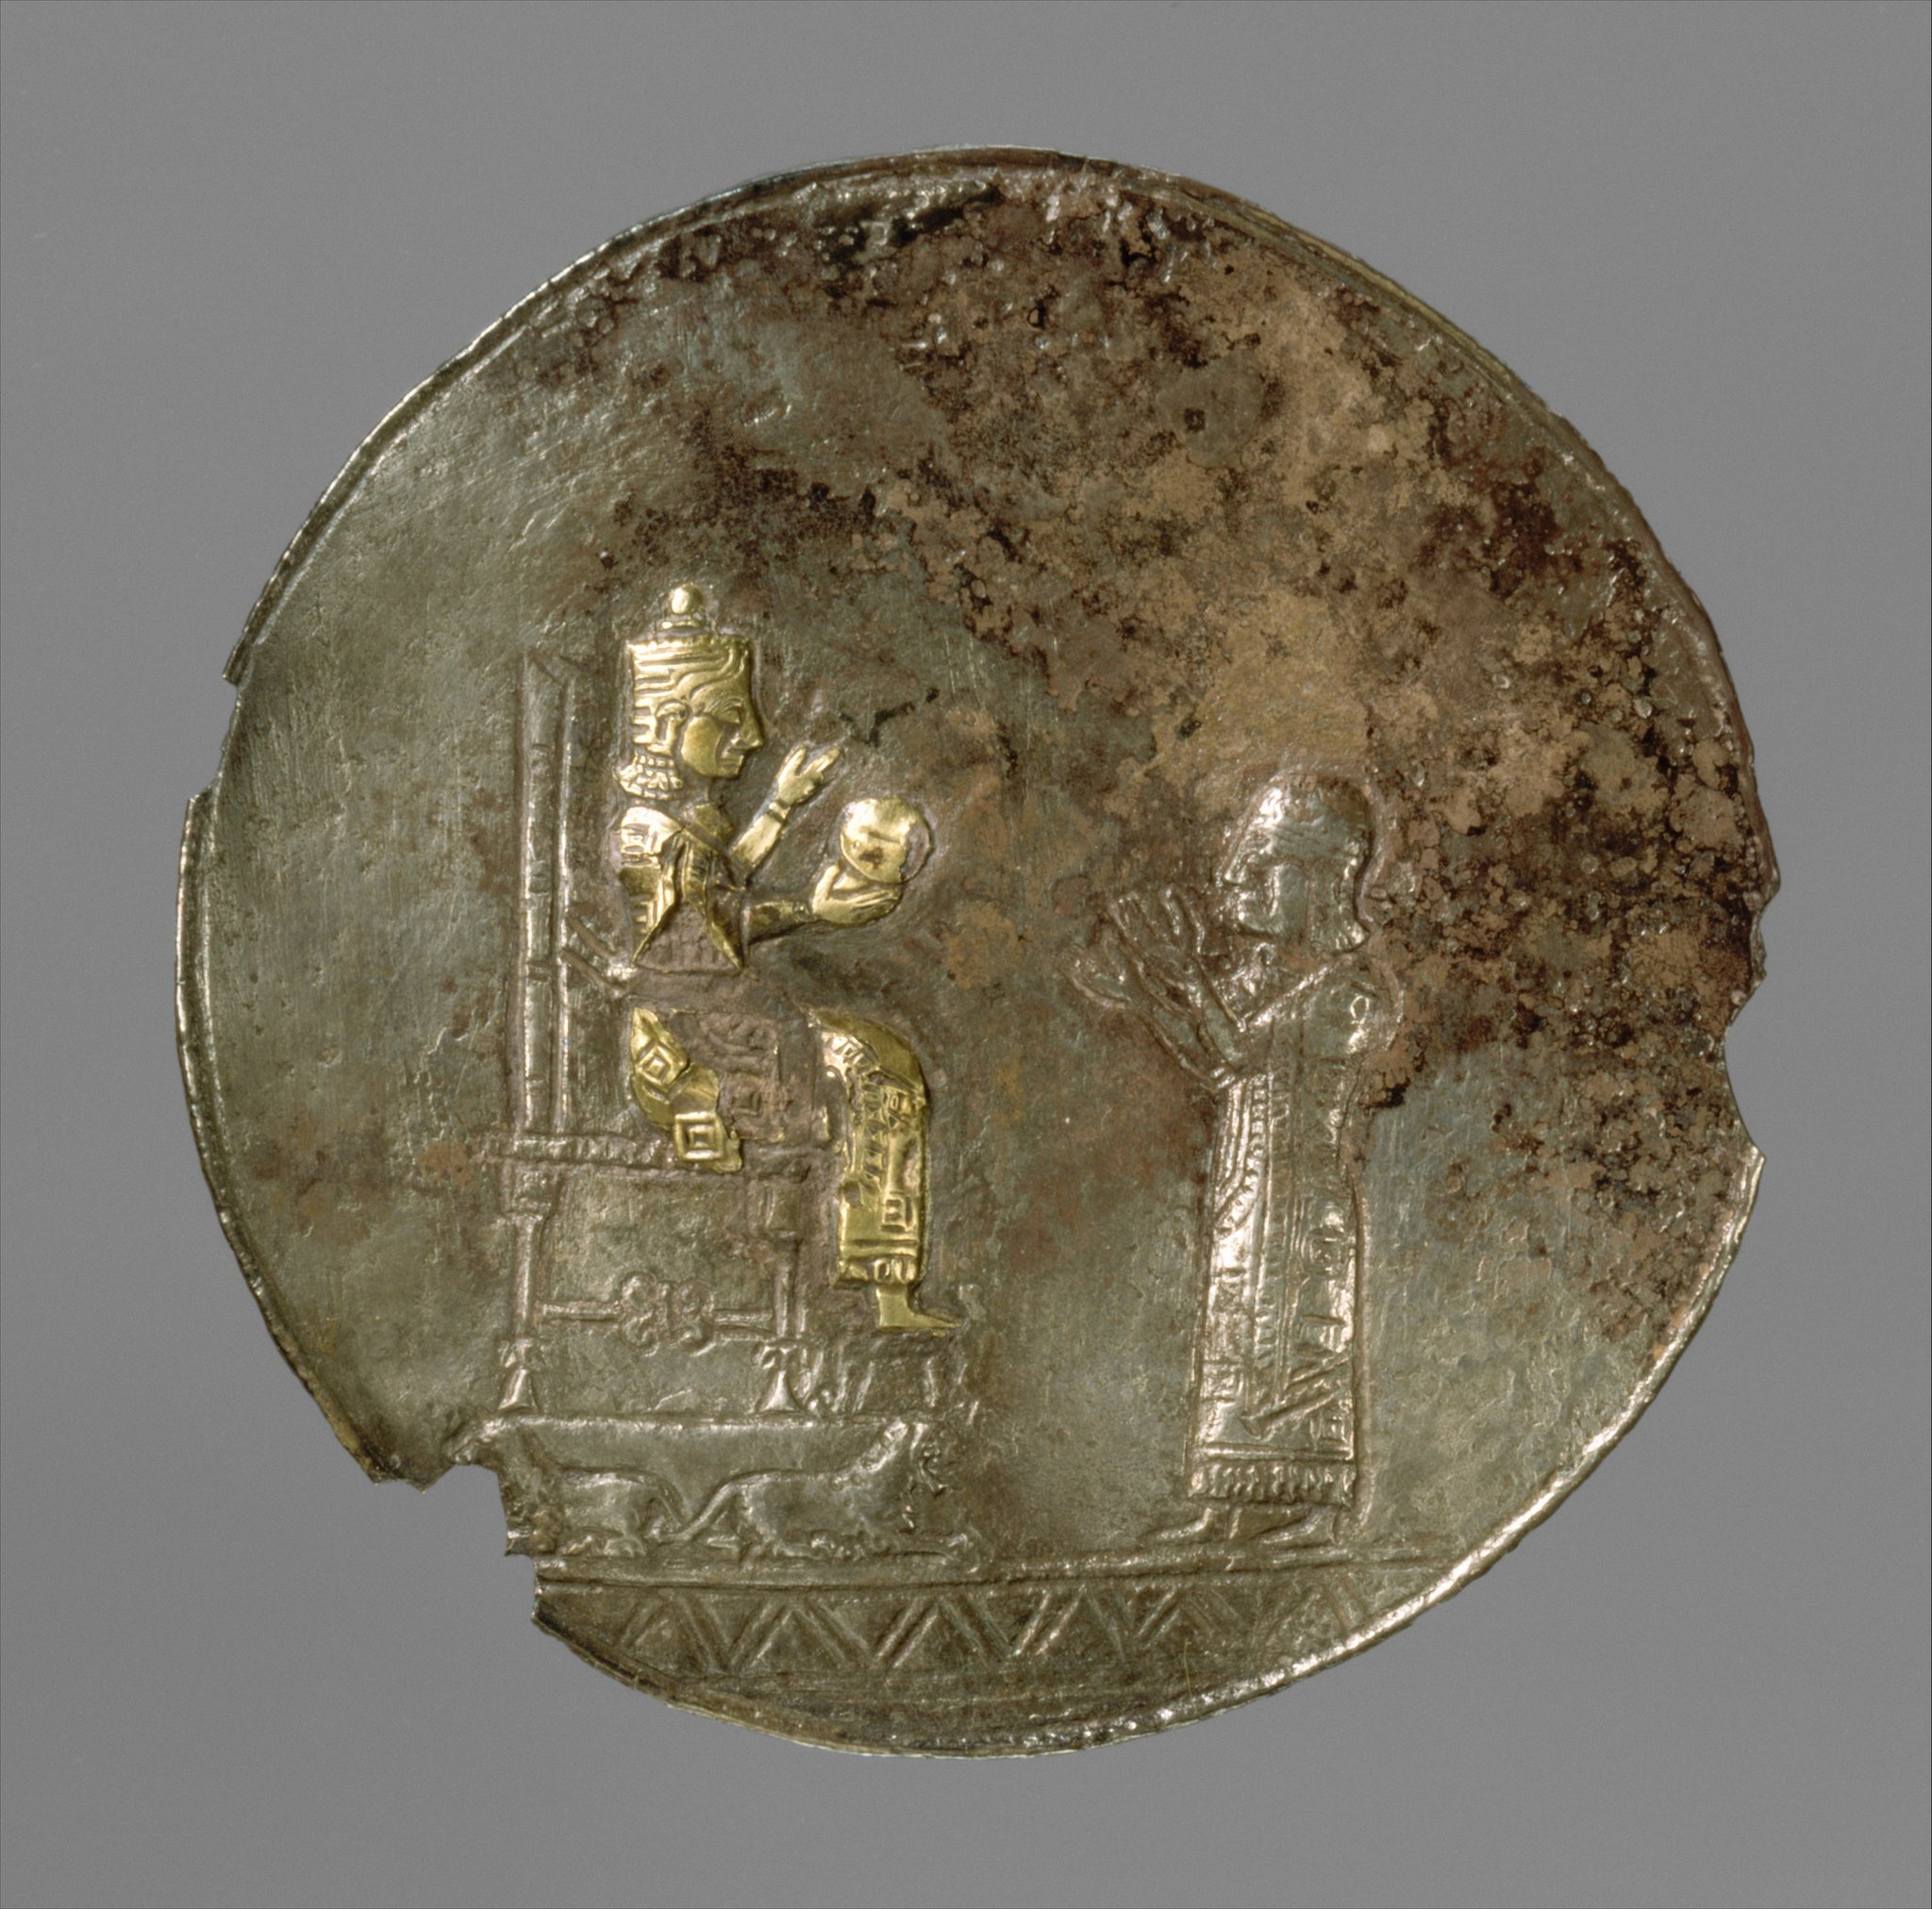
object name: medallion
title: Medallion with a seated deity and a male worshiper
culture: urartian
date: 800-601 BCE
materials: gold foil, silver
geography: urartu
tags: men,deities